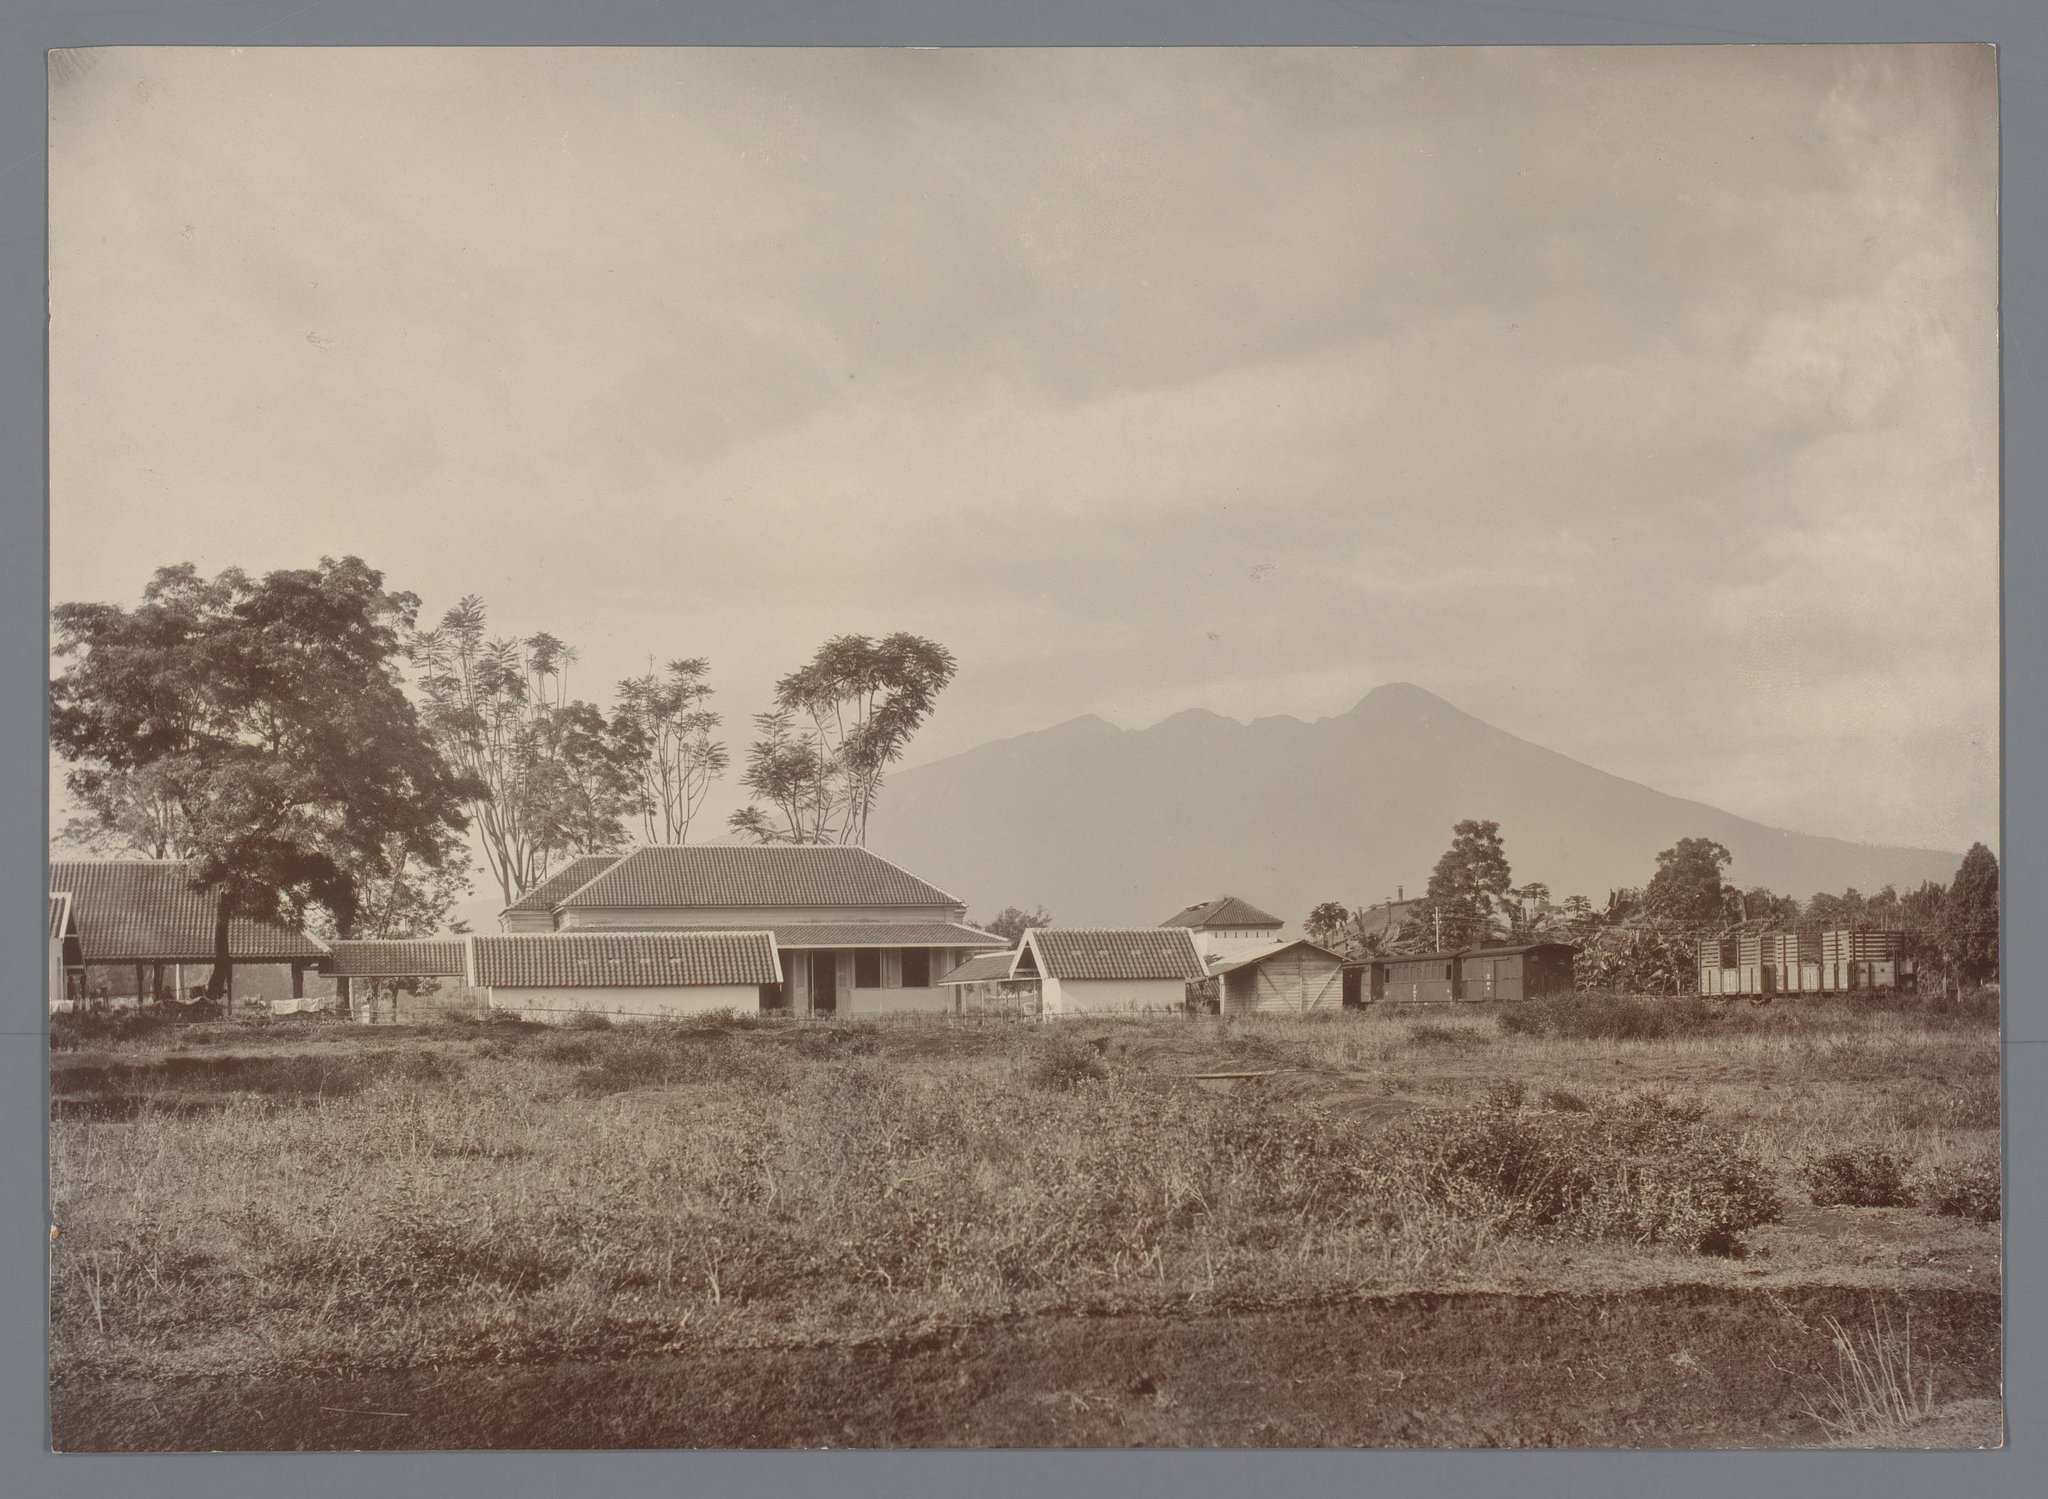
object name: photograph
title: "De Lalak", Buitenzorg (huidige Bogor), West-Java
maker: Anonymous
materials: paper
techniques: albumen print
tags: java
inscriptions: inscription: ‘Buitenzorg De Lalak//28 April tot 8 Mei’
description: "De Lalak", Buitenzorg (huidige Bogor), West-Java. Groot huizencomplex op een grasveld, met een hoge berg op de achtergrond.